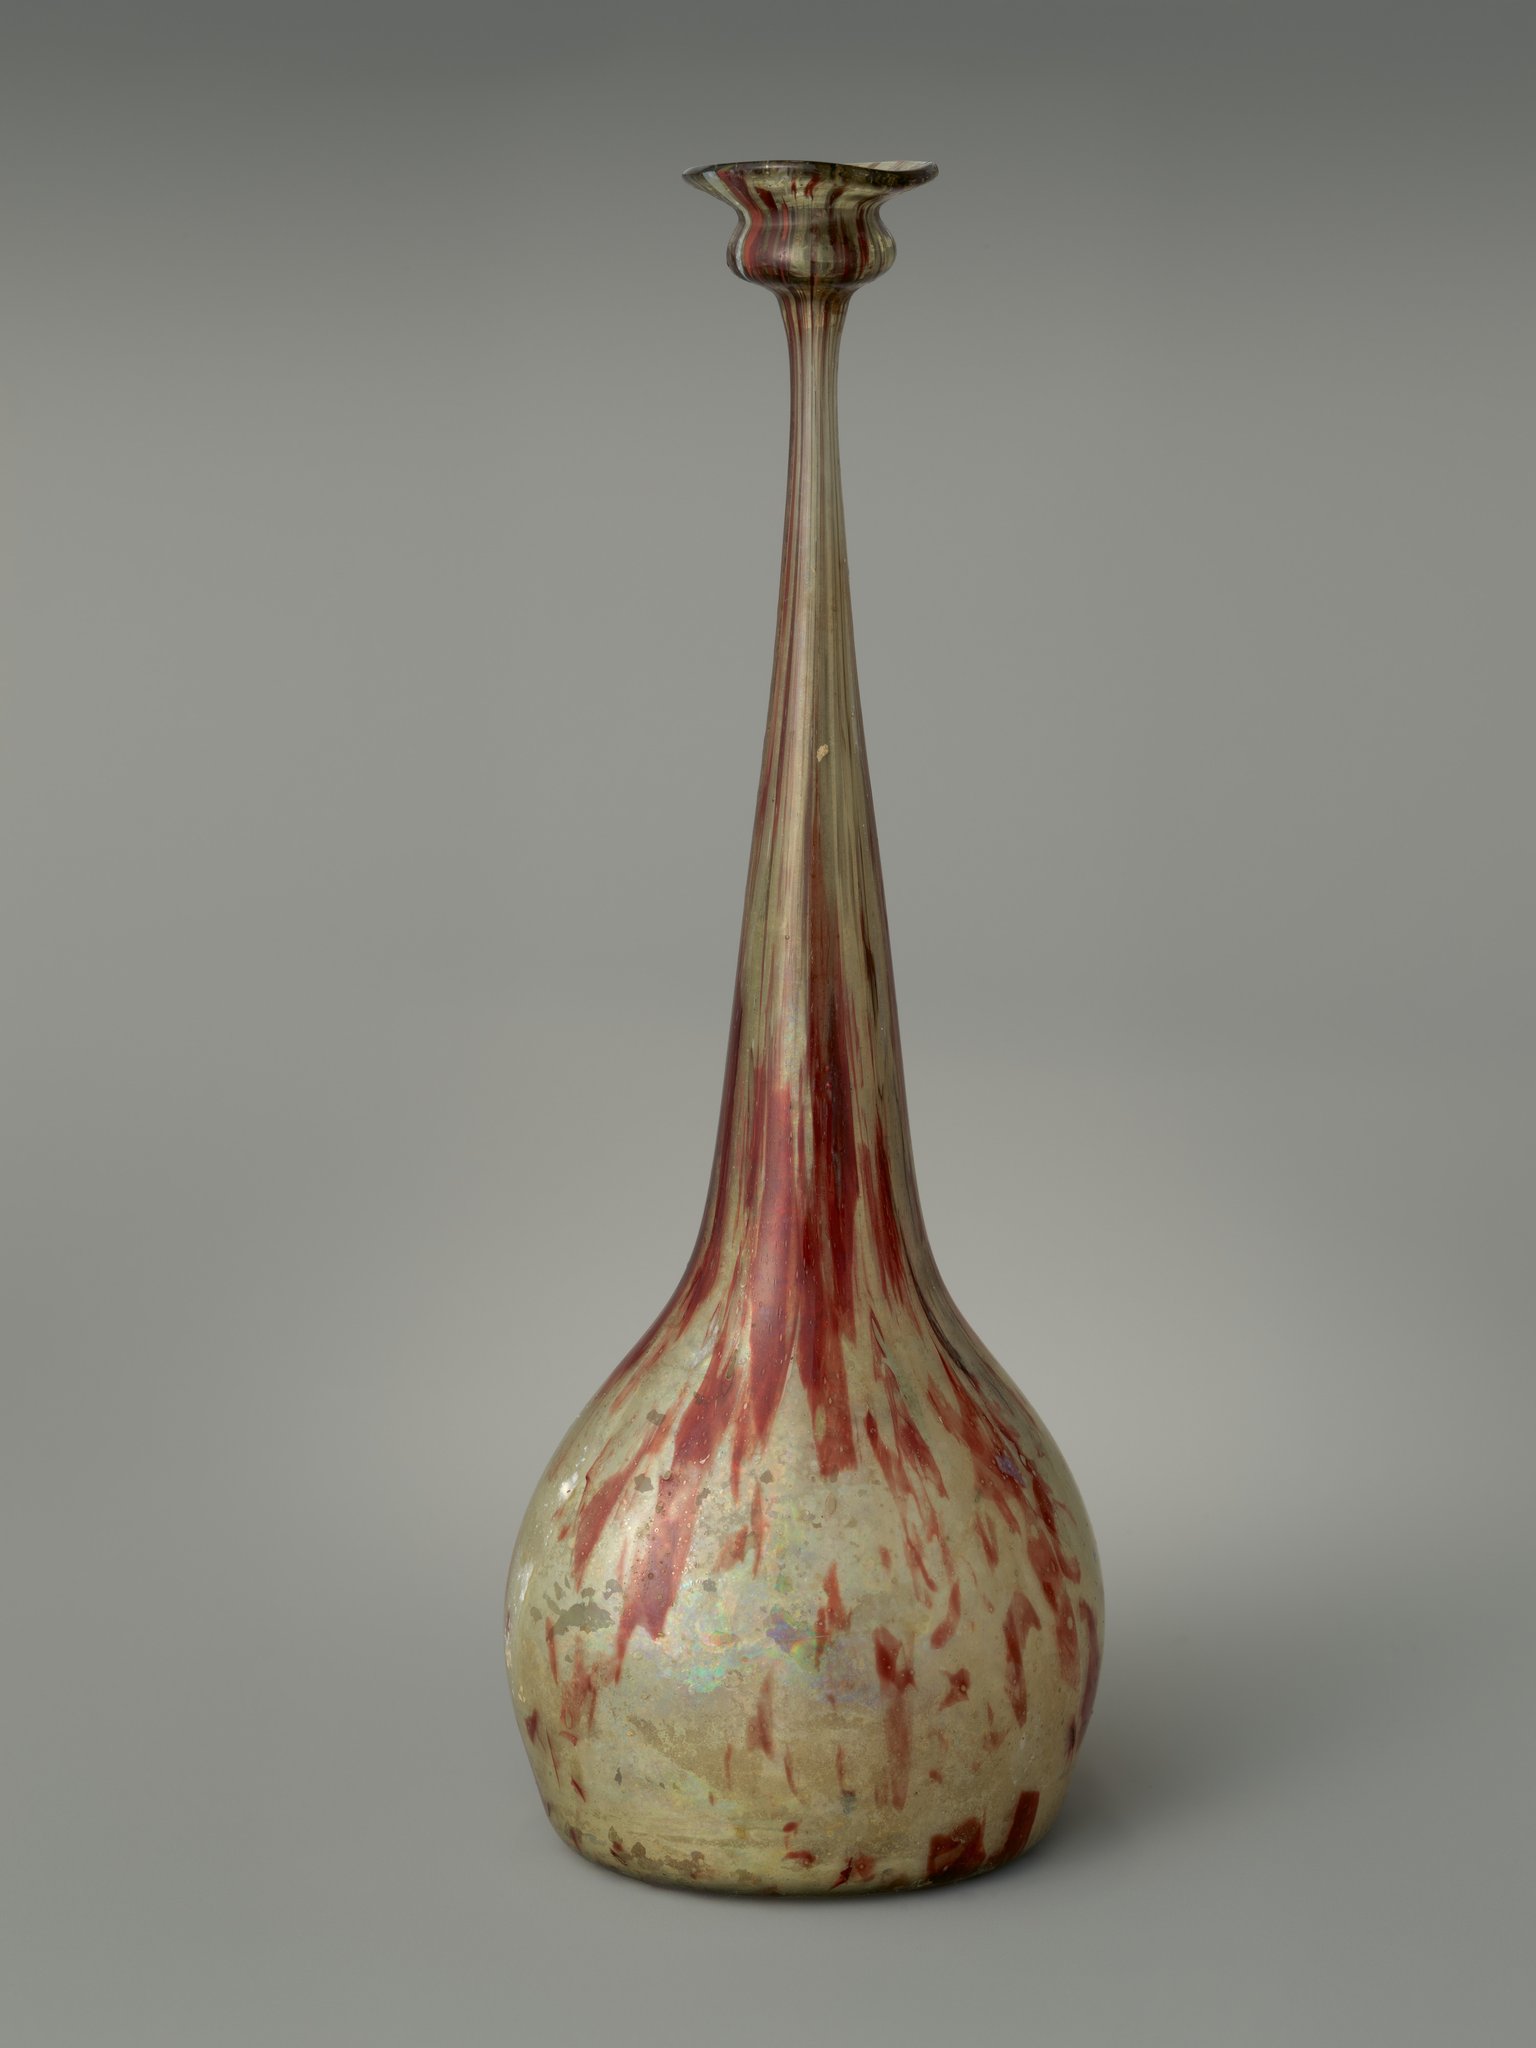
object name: bottle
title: Rosewater Sprinkler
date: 1767-1900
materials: glass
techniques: glassblowing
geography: turkey